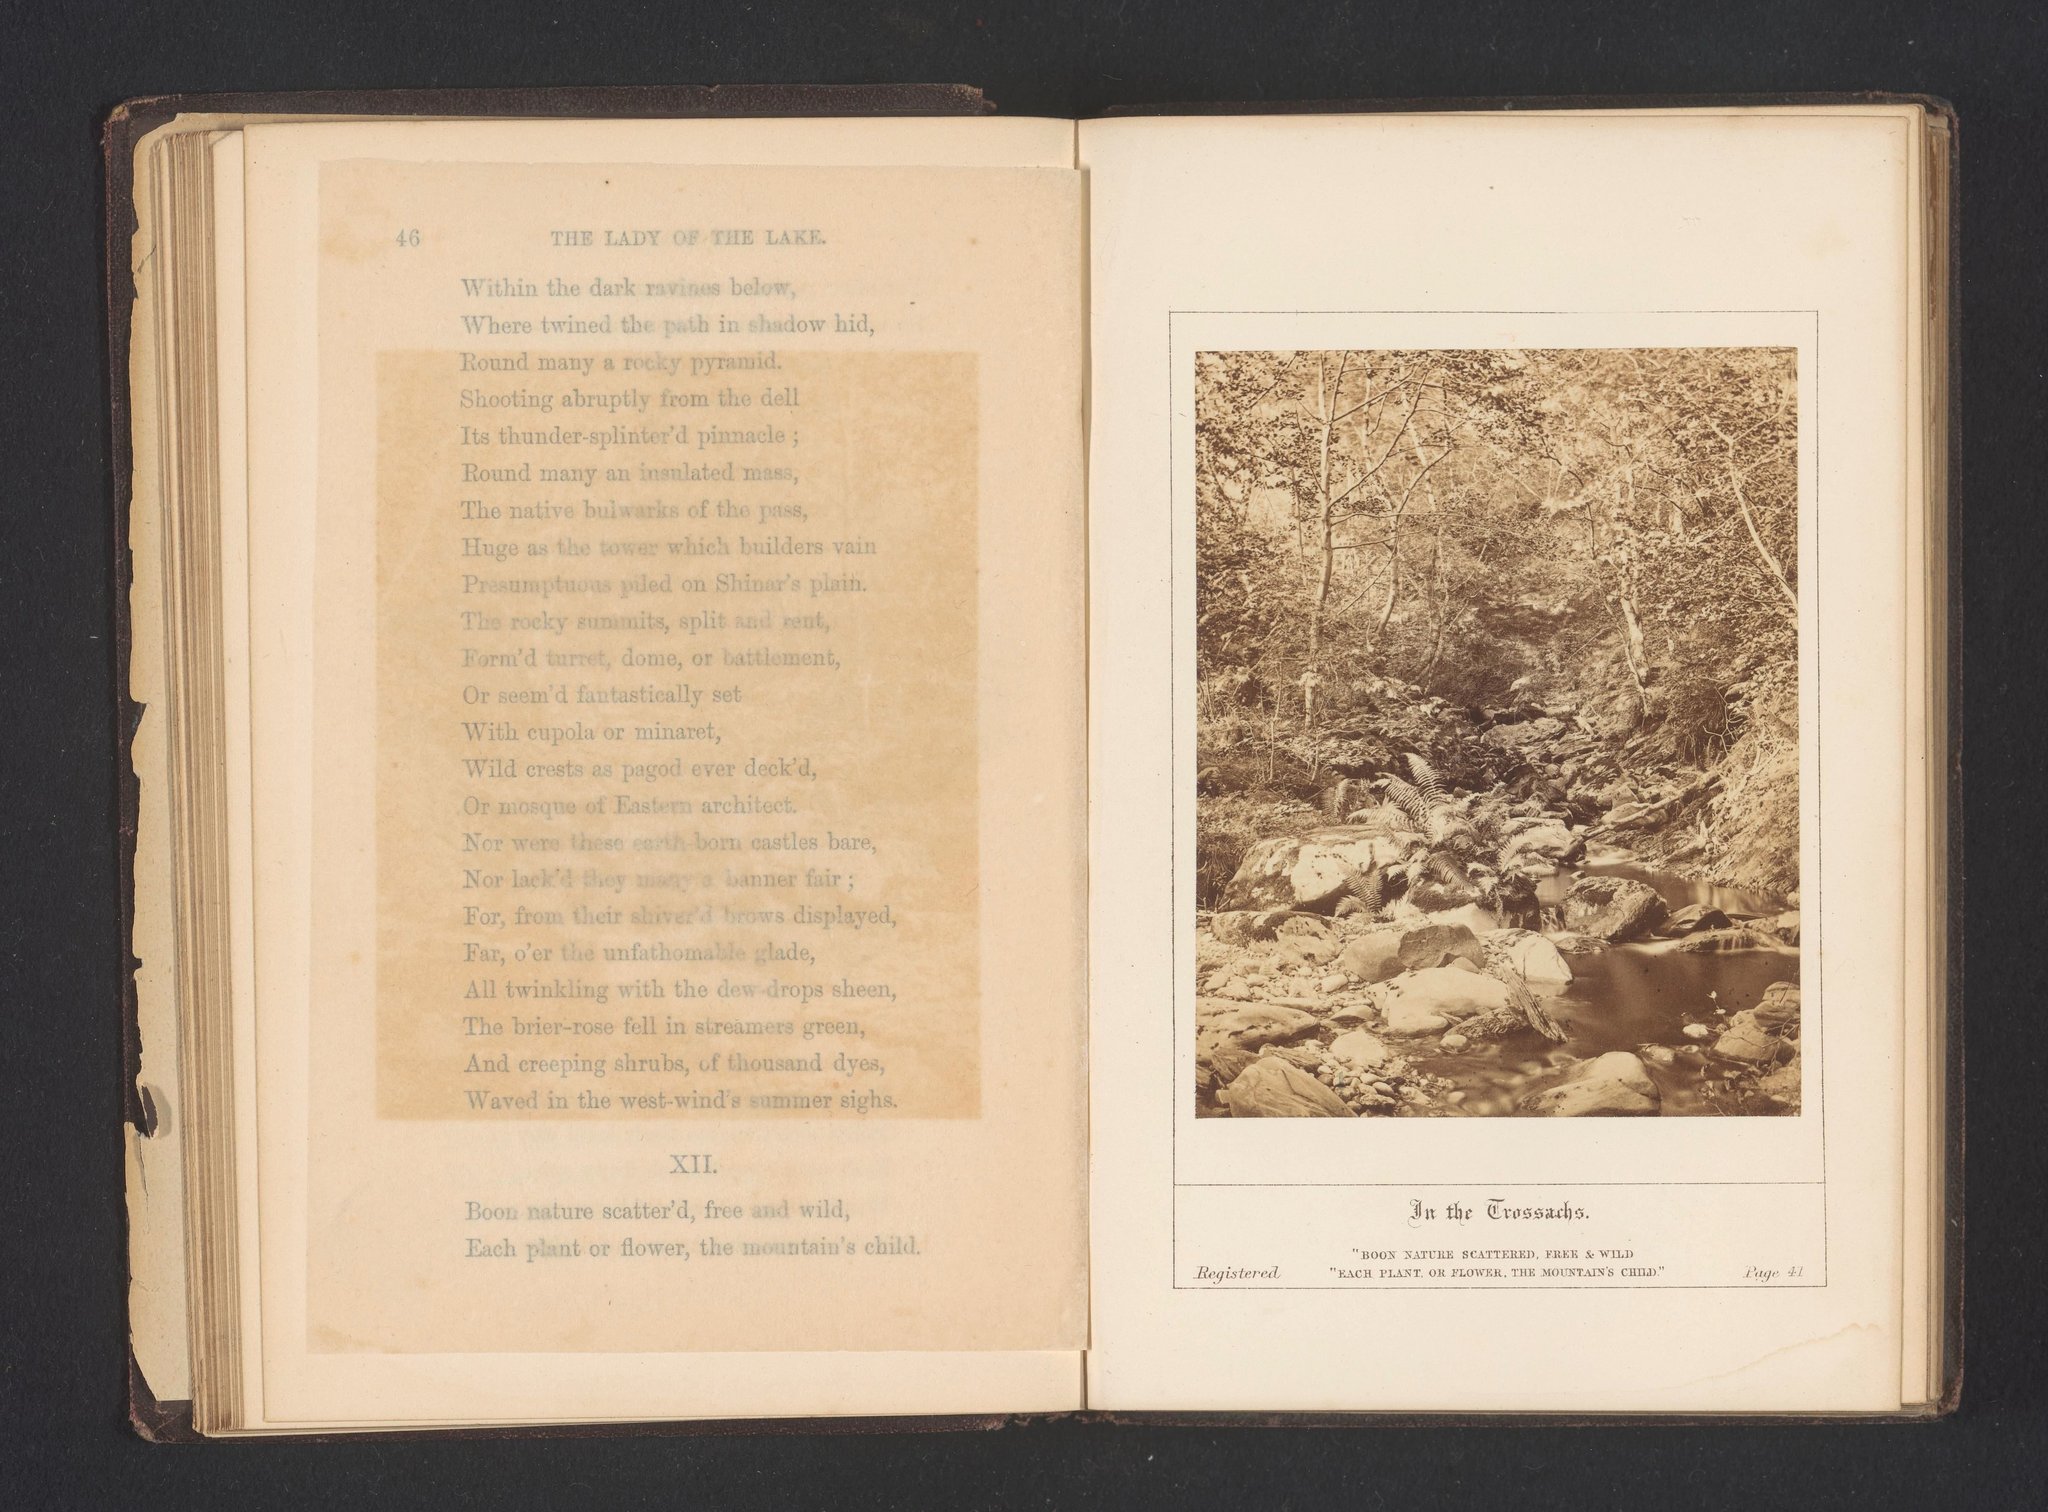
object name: page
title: In the Trossachs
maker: george washington wilson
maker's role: publisher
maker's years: 1823-1893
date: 1855-1865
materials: photographic support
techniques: albumen print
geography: trossachs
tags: river, forest, wood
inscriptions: inscription: ‘“Boon nature scattered, free & wild, “Each plant, or flower, the mountains' child.”’, number: ‘Page 41.’